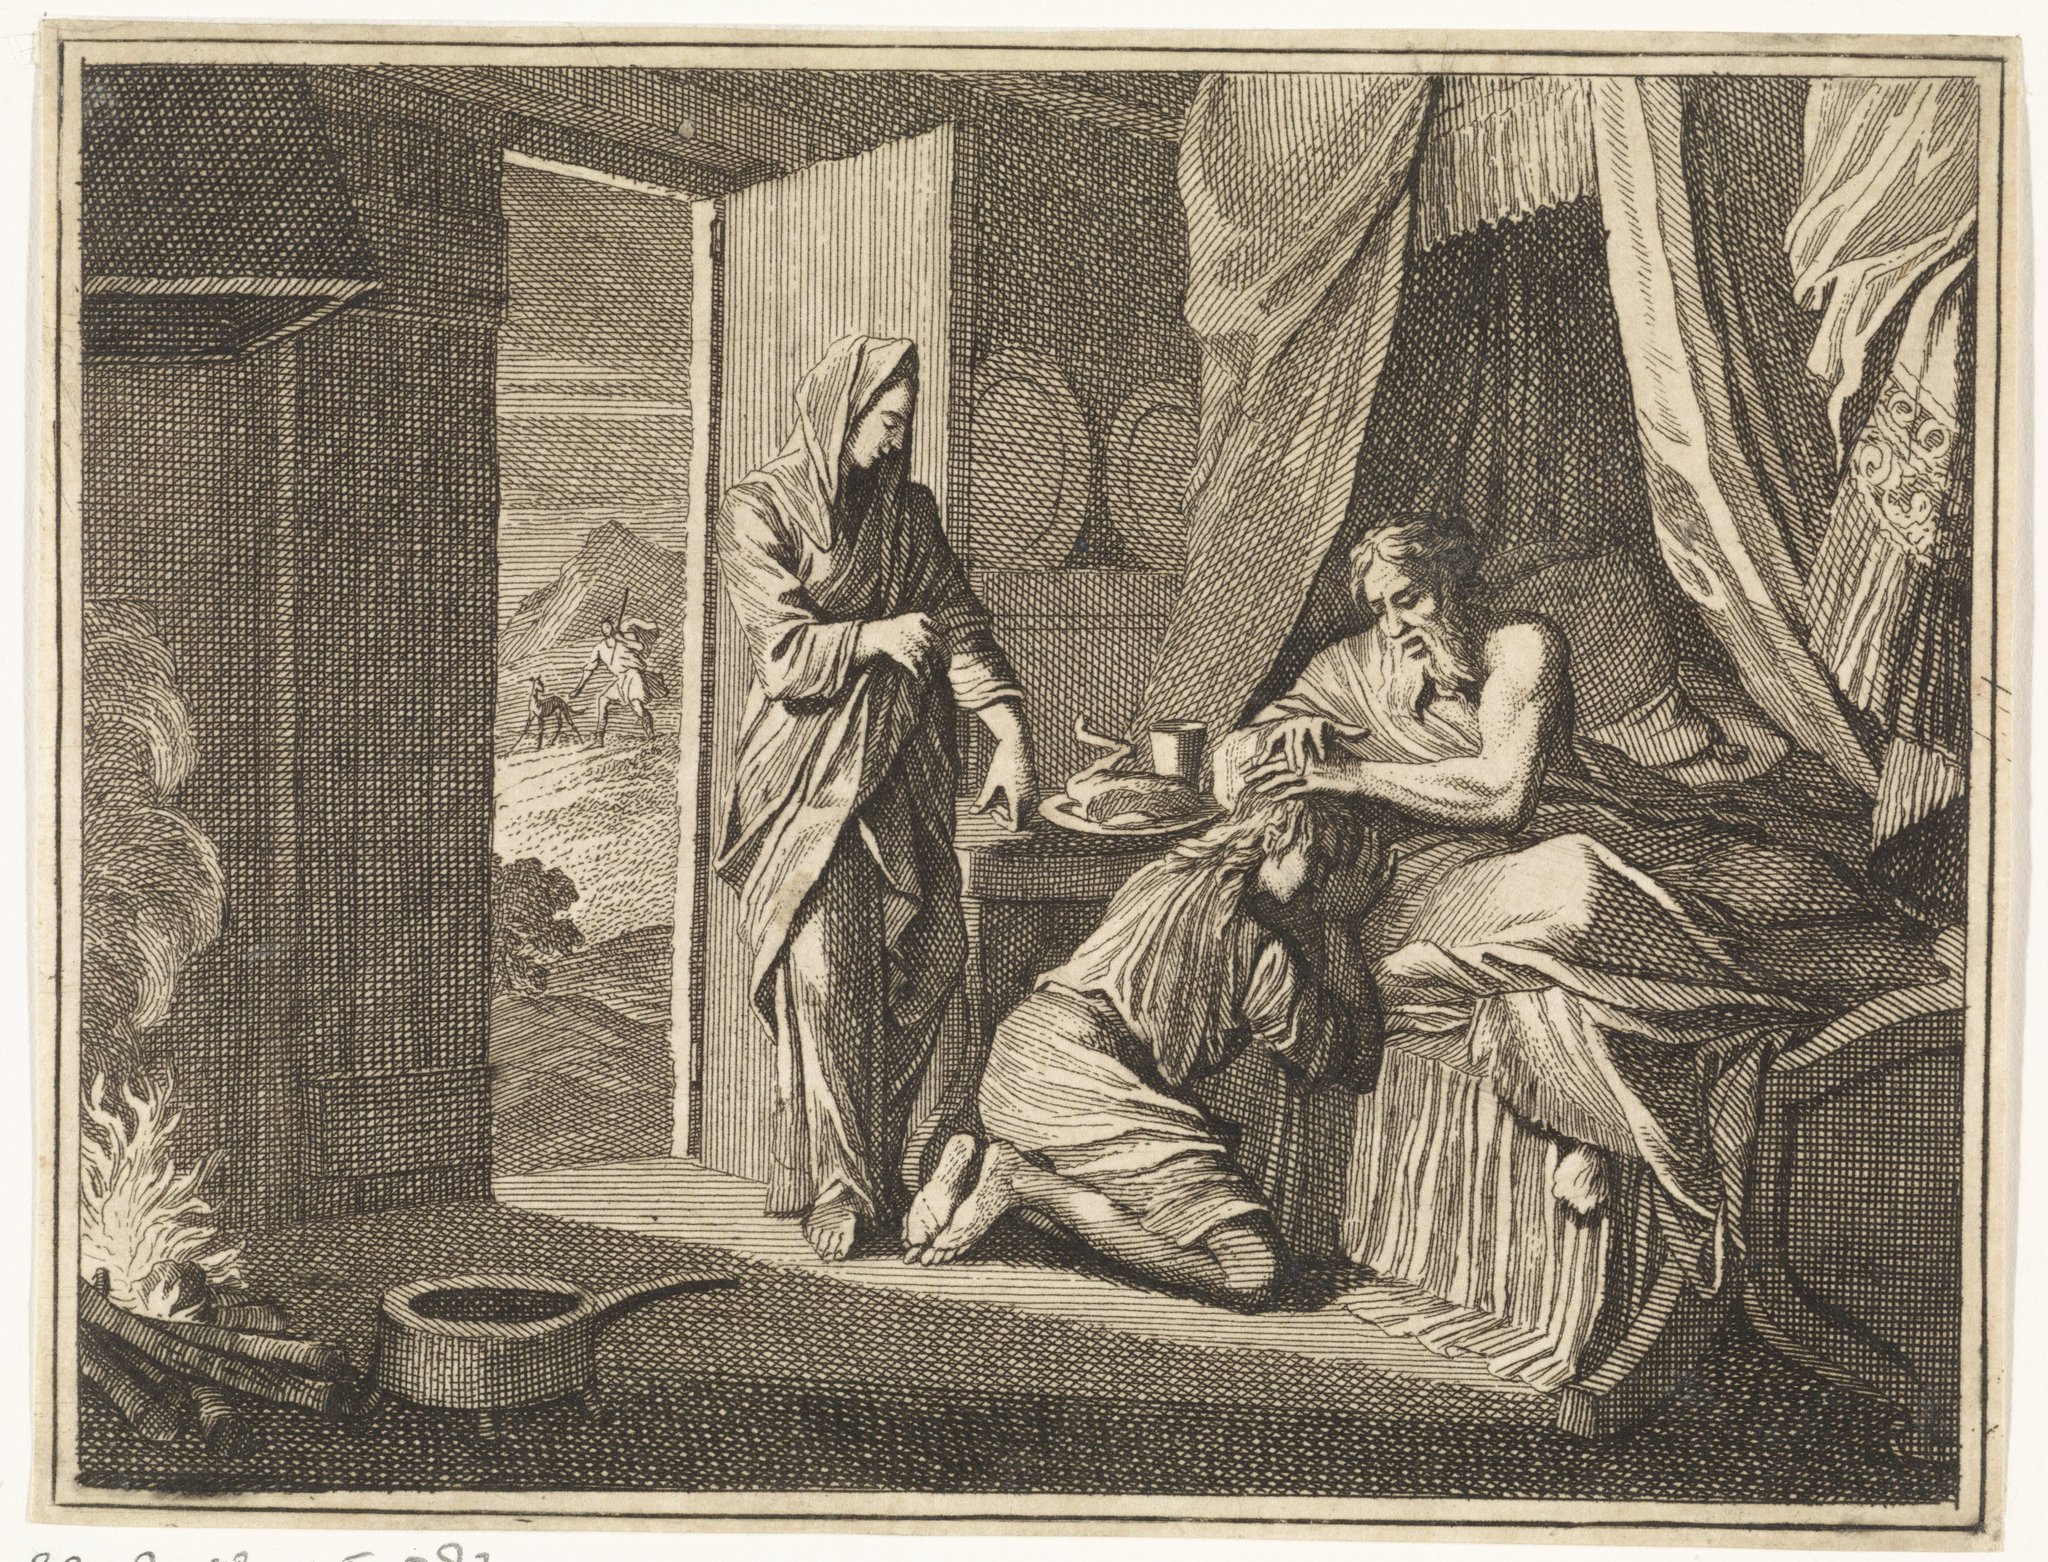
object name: print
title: Isaak zegent Jakob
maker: caspar luyken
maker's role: draughtsman, print maker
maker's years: 1672-1708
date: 1712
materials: paper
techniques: etching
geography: amsterdam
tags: isaac lying in bed blesses jacob who, disguised in esau's clothes, brings food to his father; jacob's hands and neck are covered with goatskins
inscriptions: collector's mark: Lugt 2228, number: ‘29’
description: Illustratie uit: Luyken, Jan. De schriftuurlyke geschiedenissen en gelykenissen van het Oude en Nieuwe Verbond, 2 delen. Amsterdam: Wed. Pieter Arentsz II en Cornelis van der Sys, 1712, dl. I.